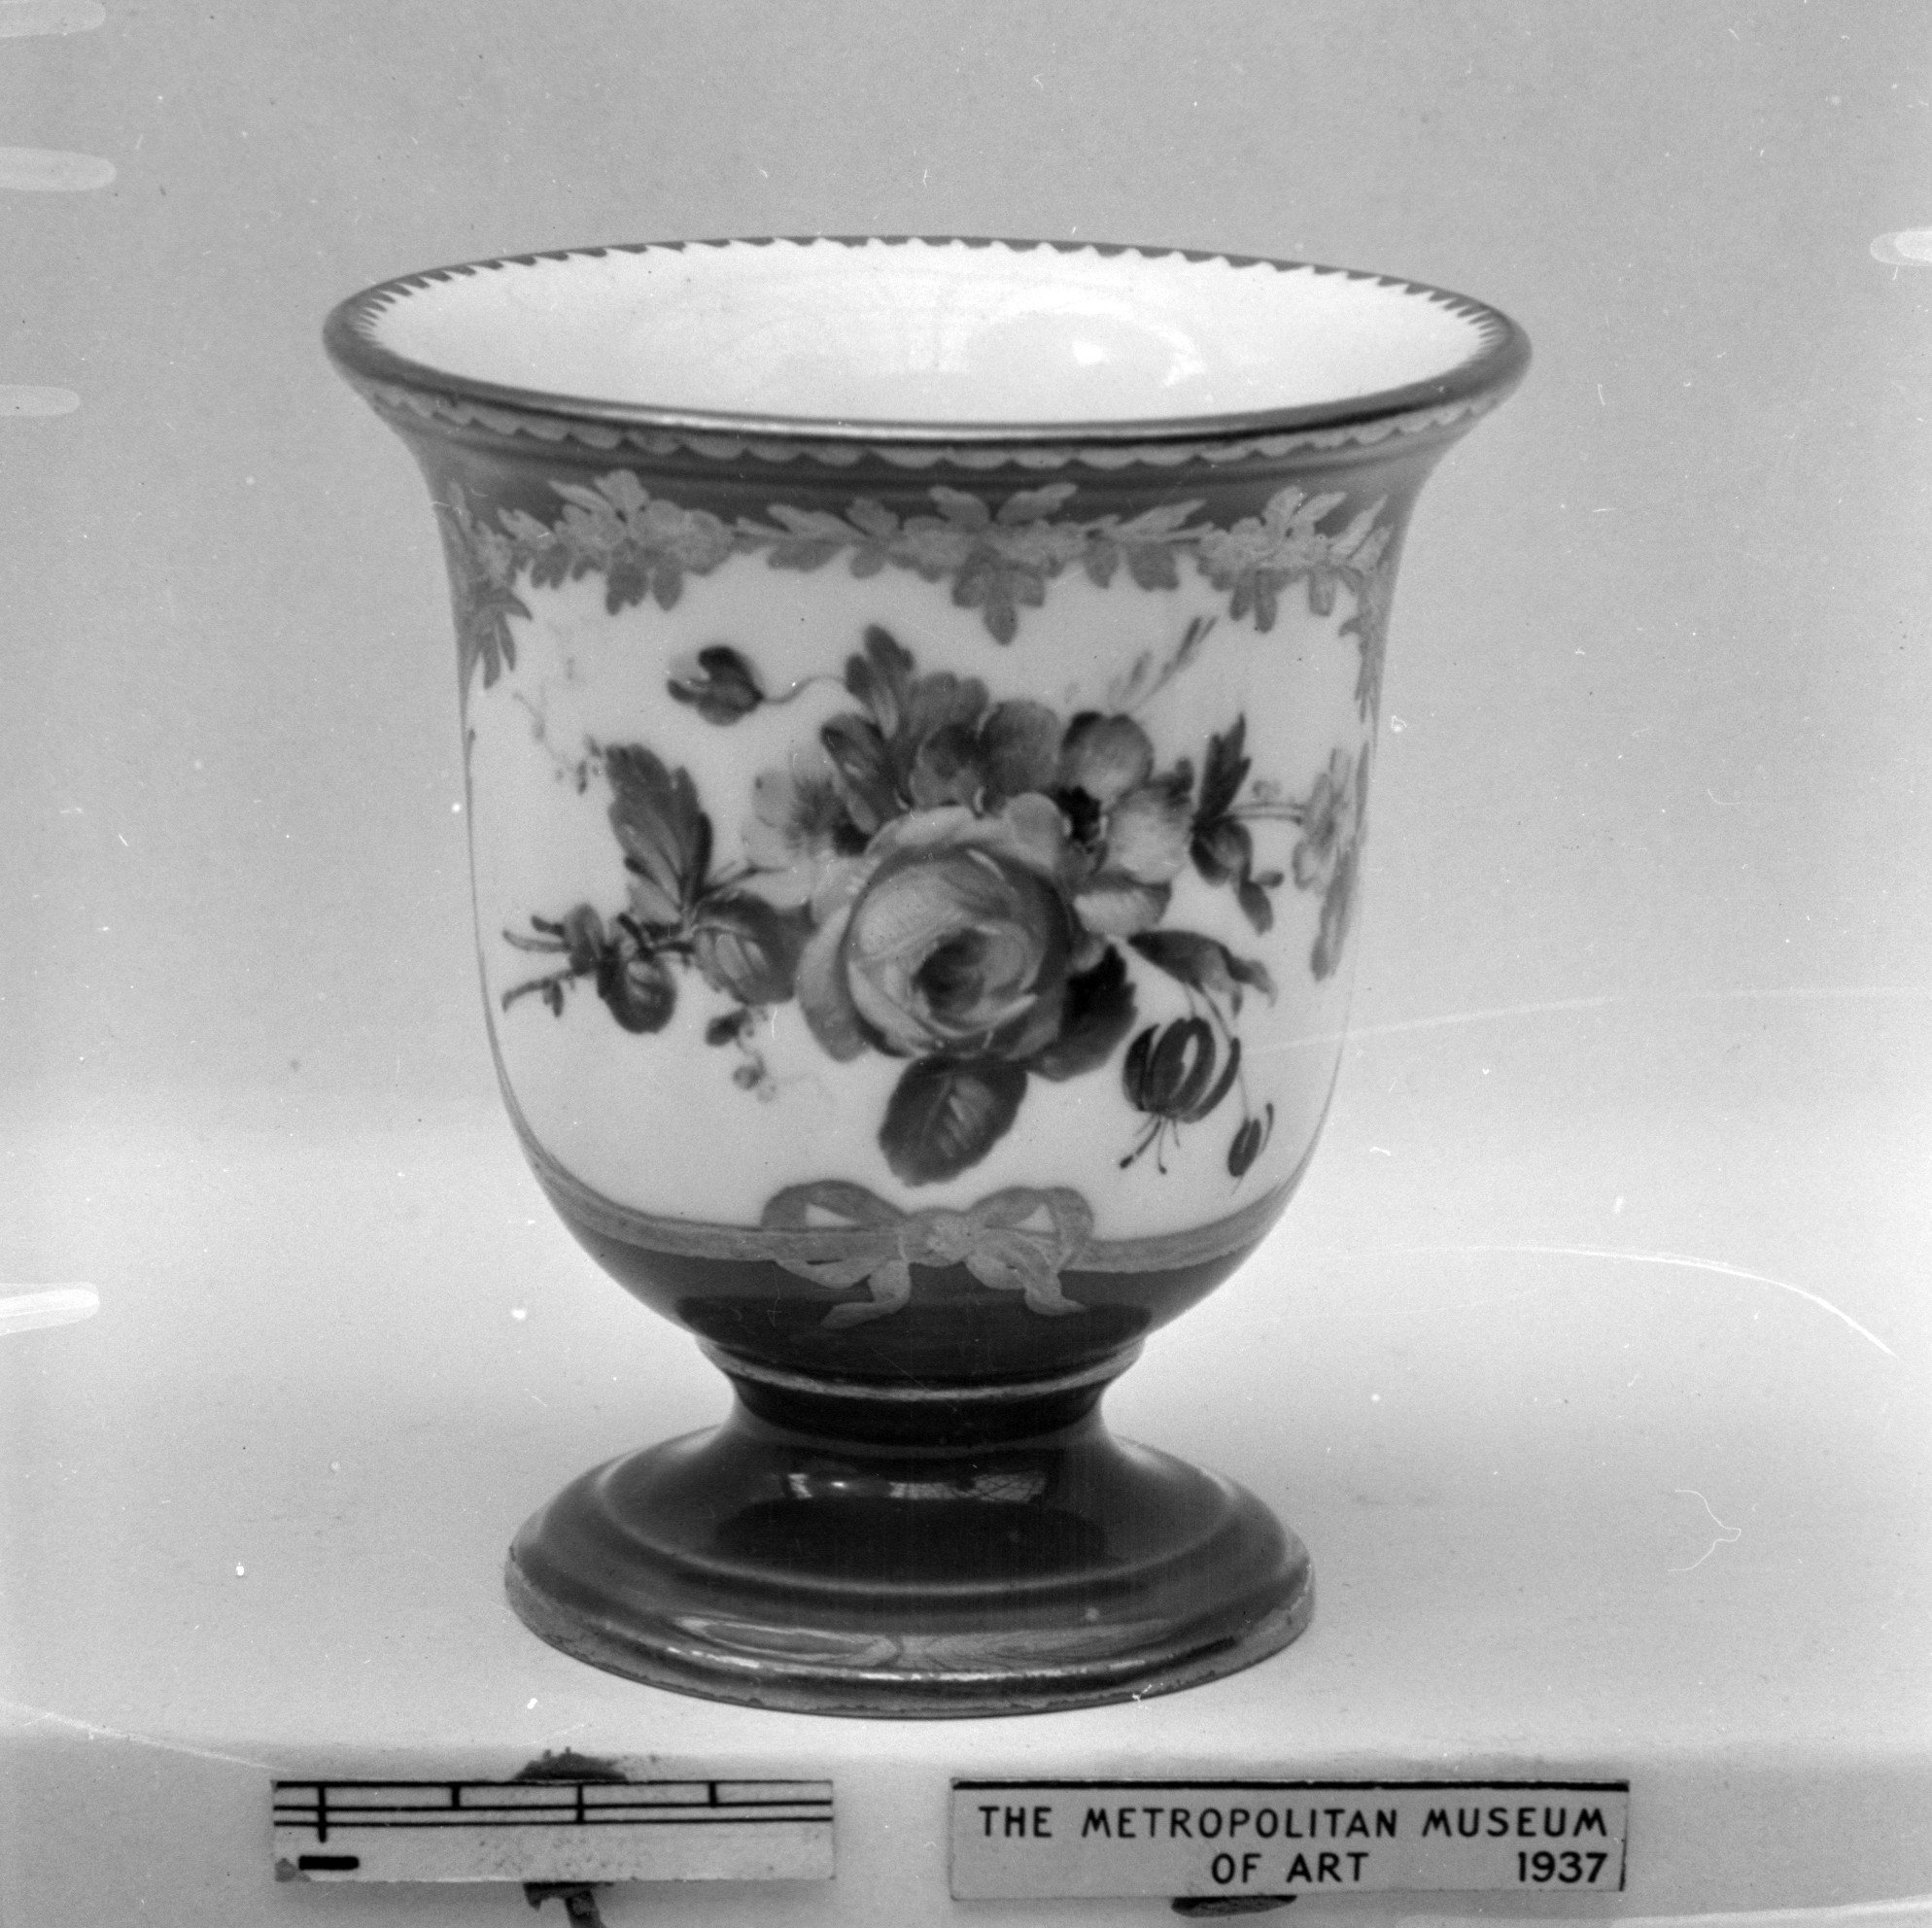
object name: ice cream cup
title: Ice cream cup (Tasse à glace) (part of a service)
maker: sèvres manufactory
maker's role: manufactory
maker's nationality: french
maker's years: 1740-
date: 1771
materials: soft paste porcelain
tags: flowers